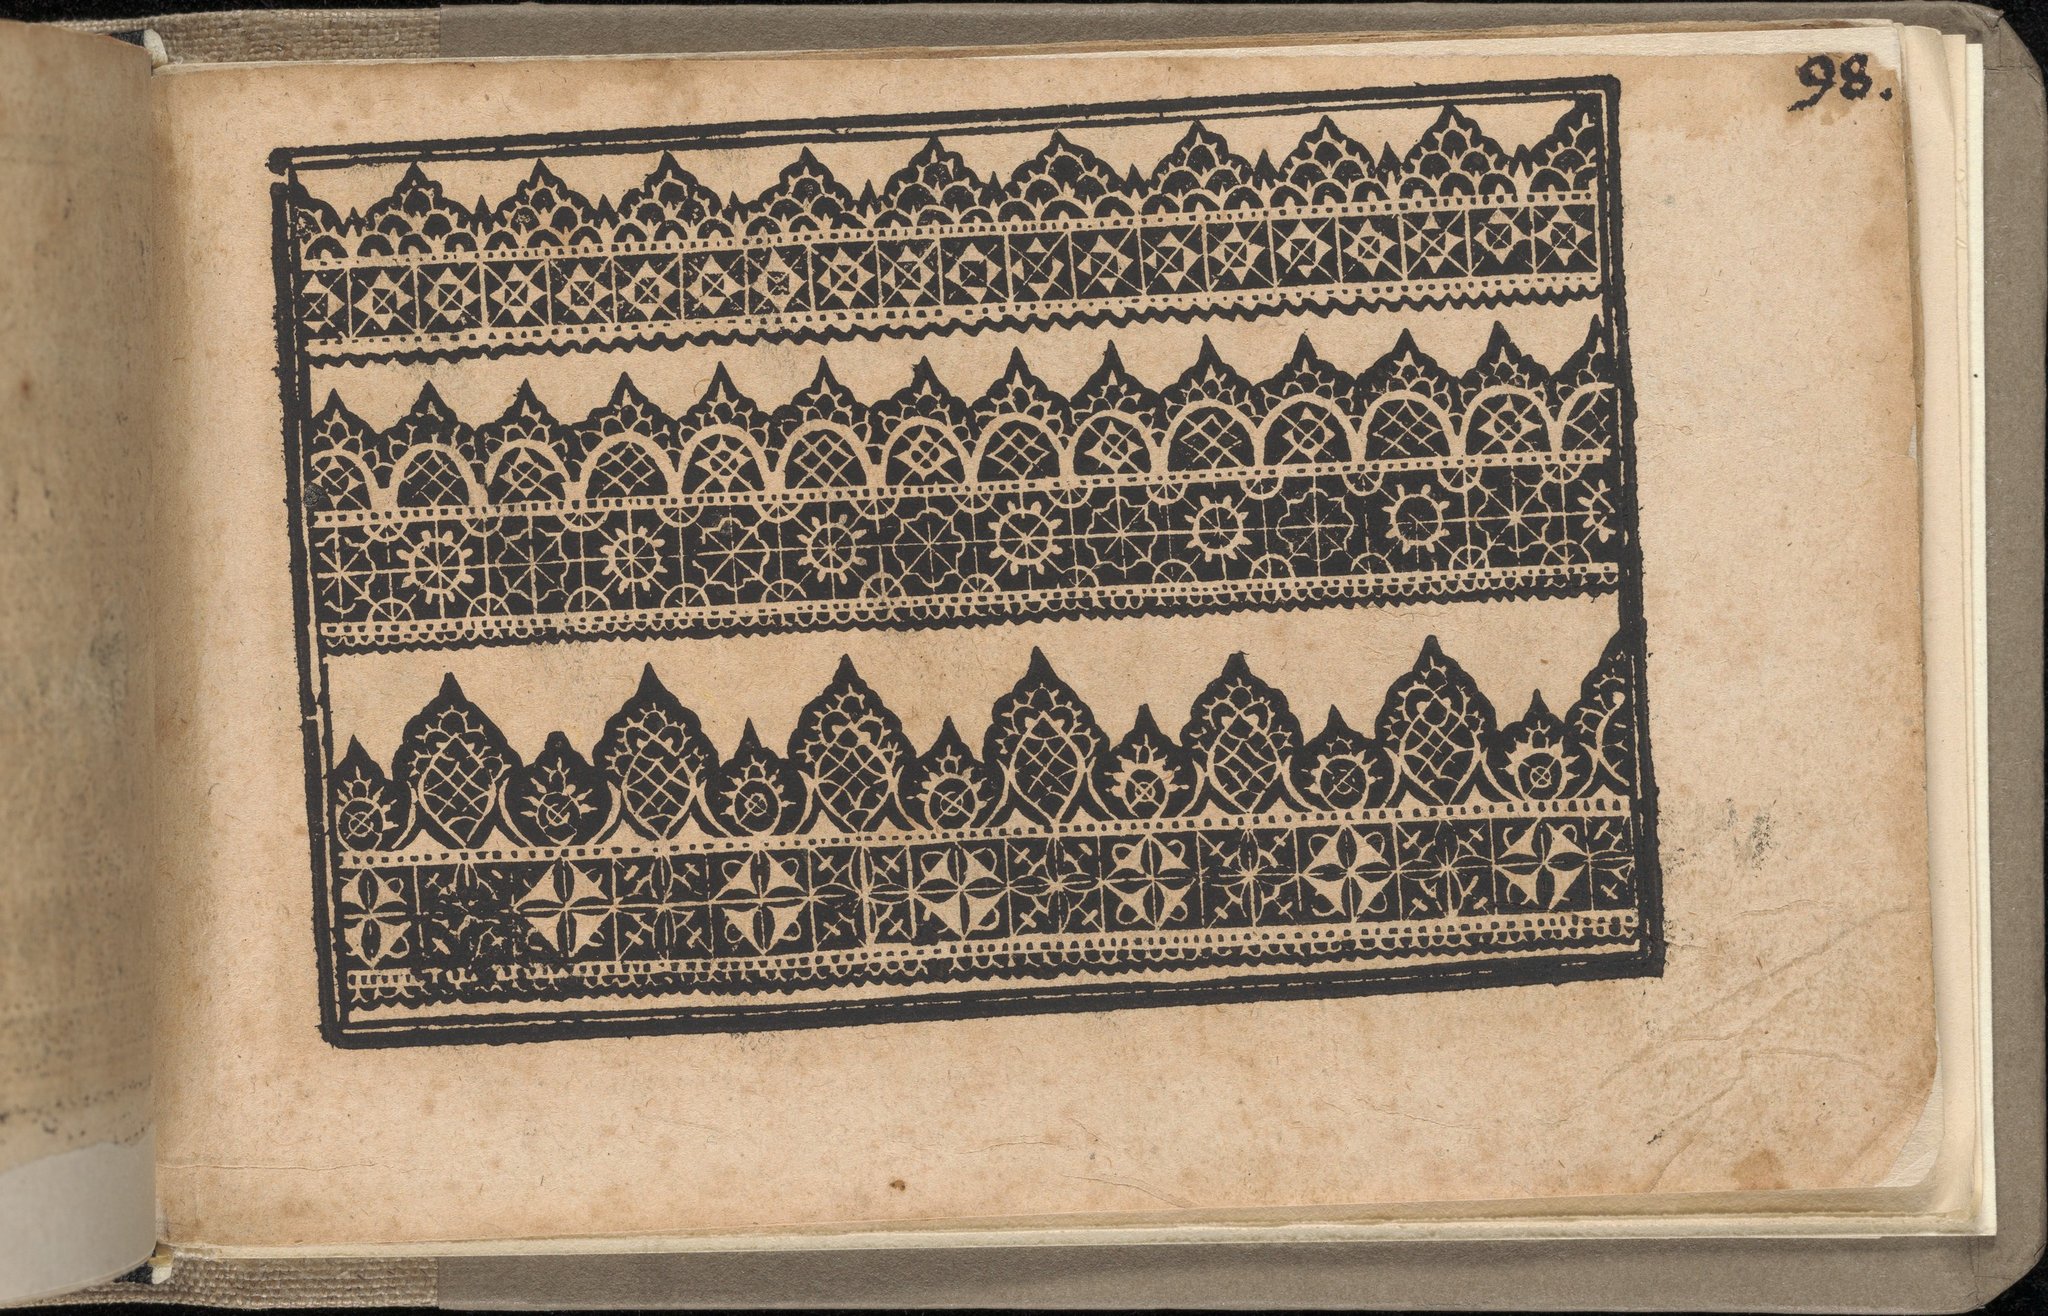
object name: book print ornament architecture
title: Schön newes Modelbuch (Page 98r)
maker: sigismundus latomus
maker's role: publisher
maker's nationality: german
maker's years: 1599-1632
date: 1608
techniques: woodcut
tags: ornament